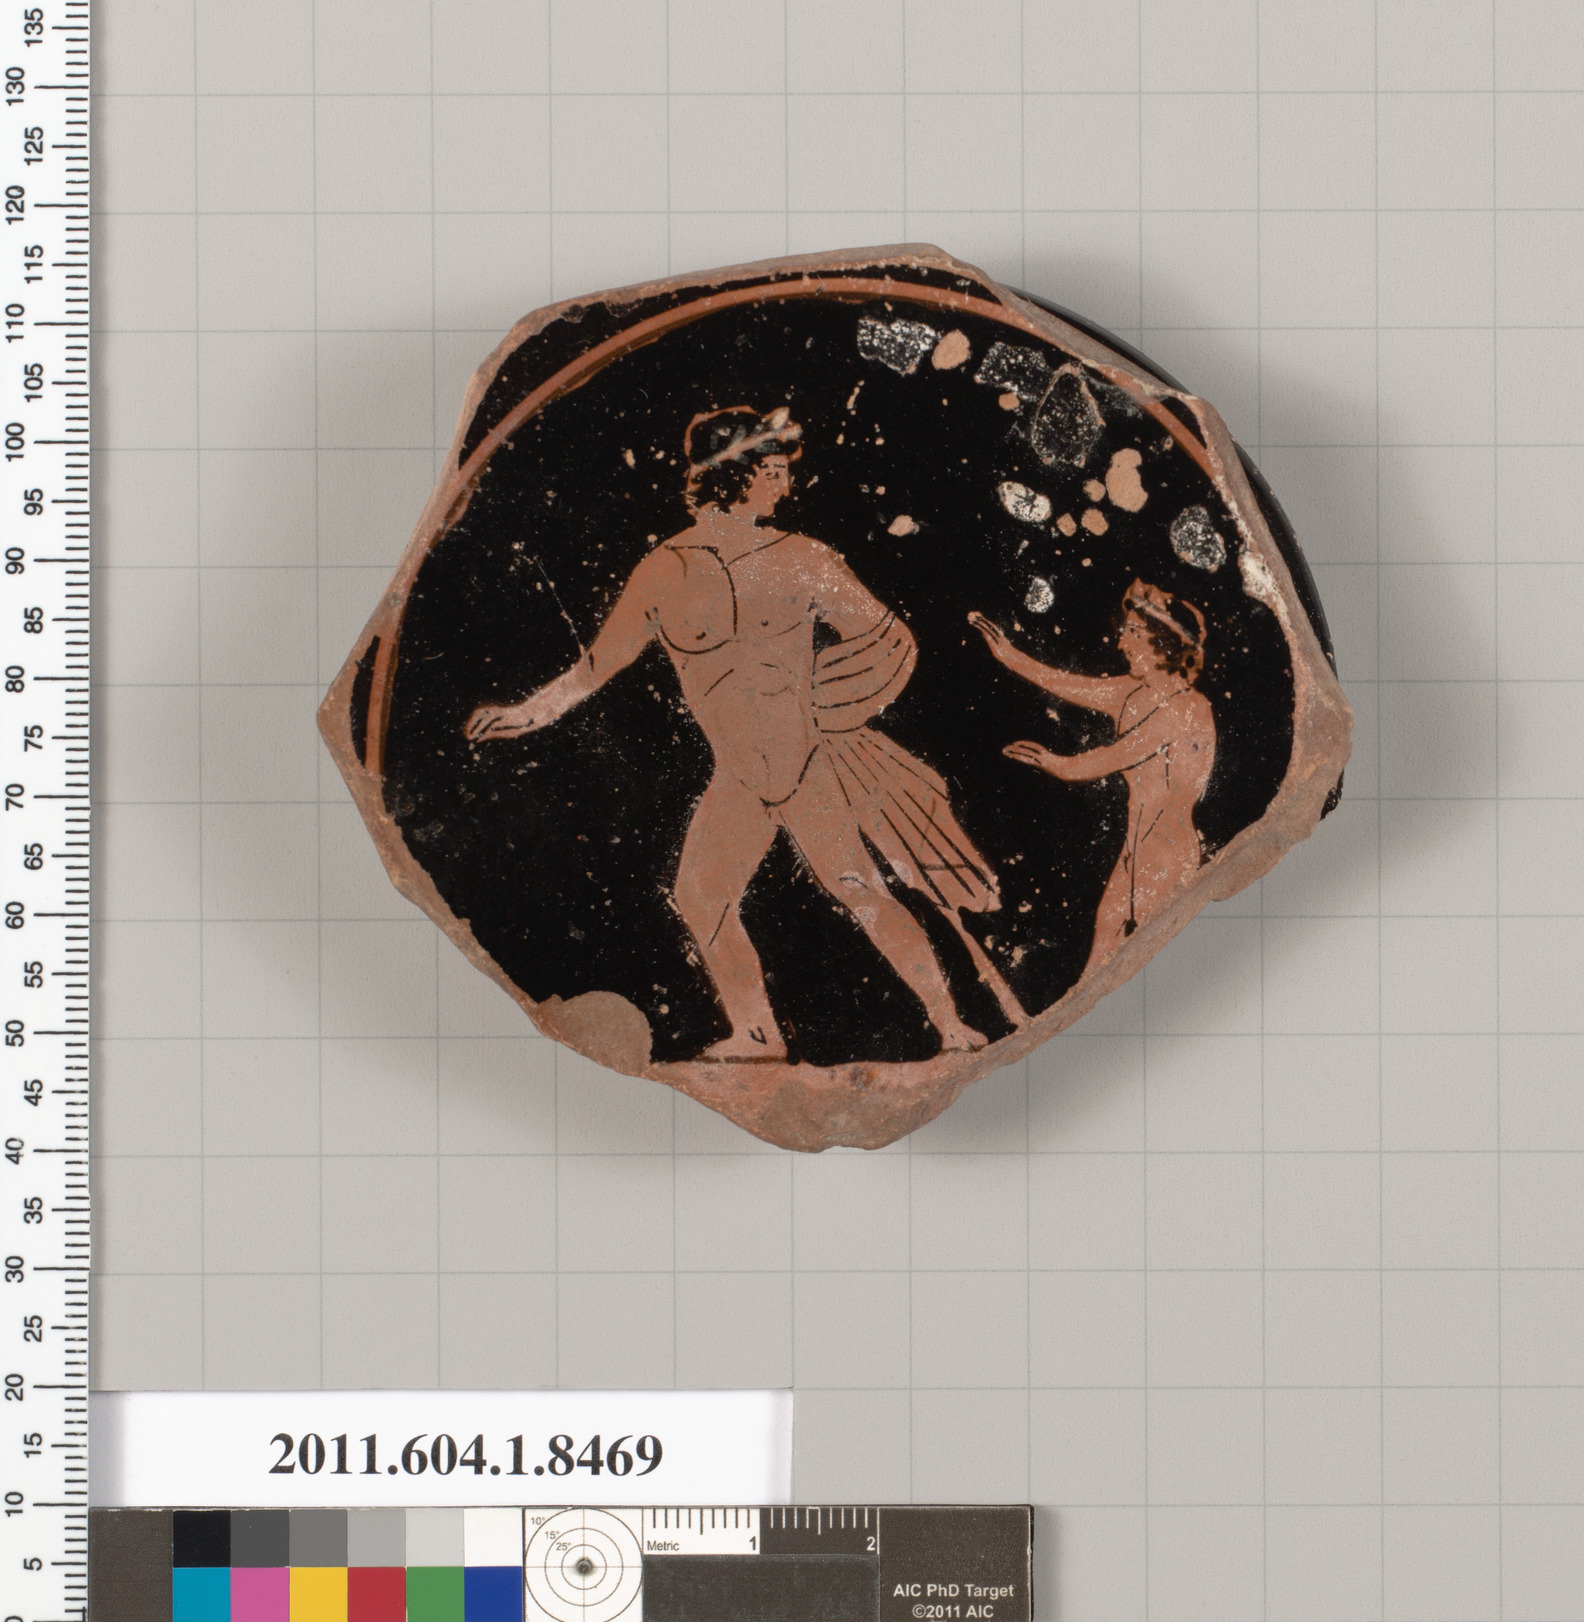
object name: kylix fragment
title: Terracotta fragment of a stemless kylix (drinking cup)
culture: greek, attic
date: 467-435 BCE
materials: terracotta